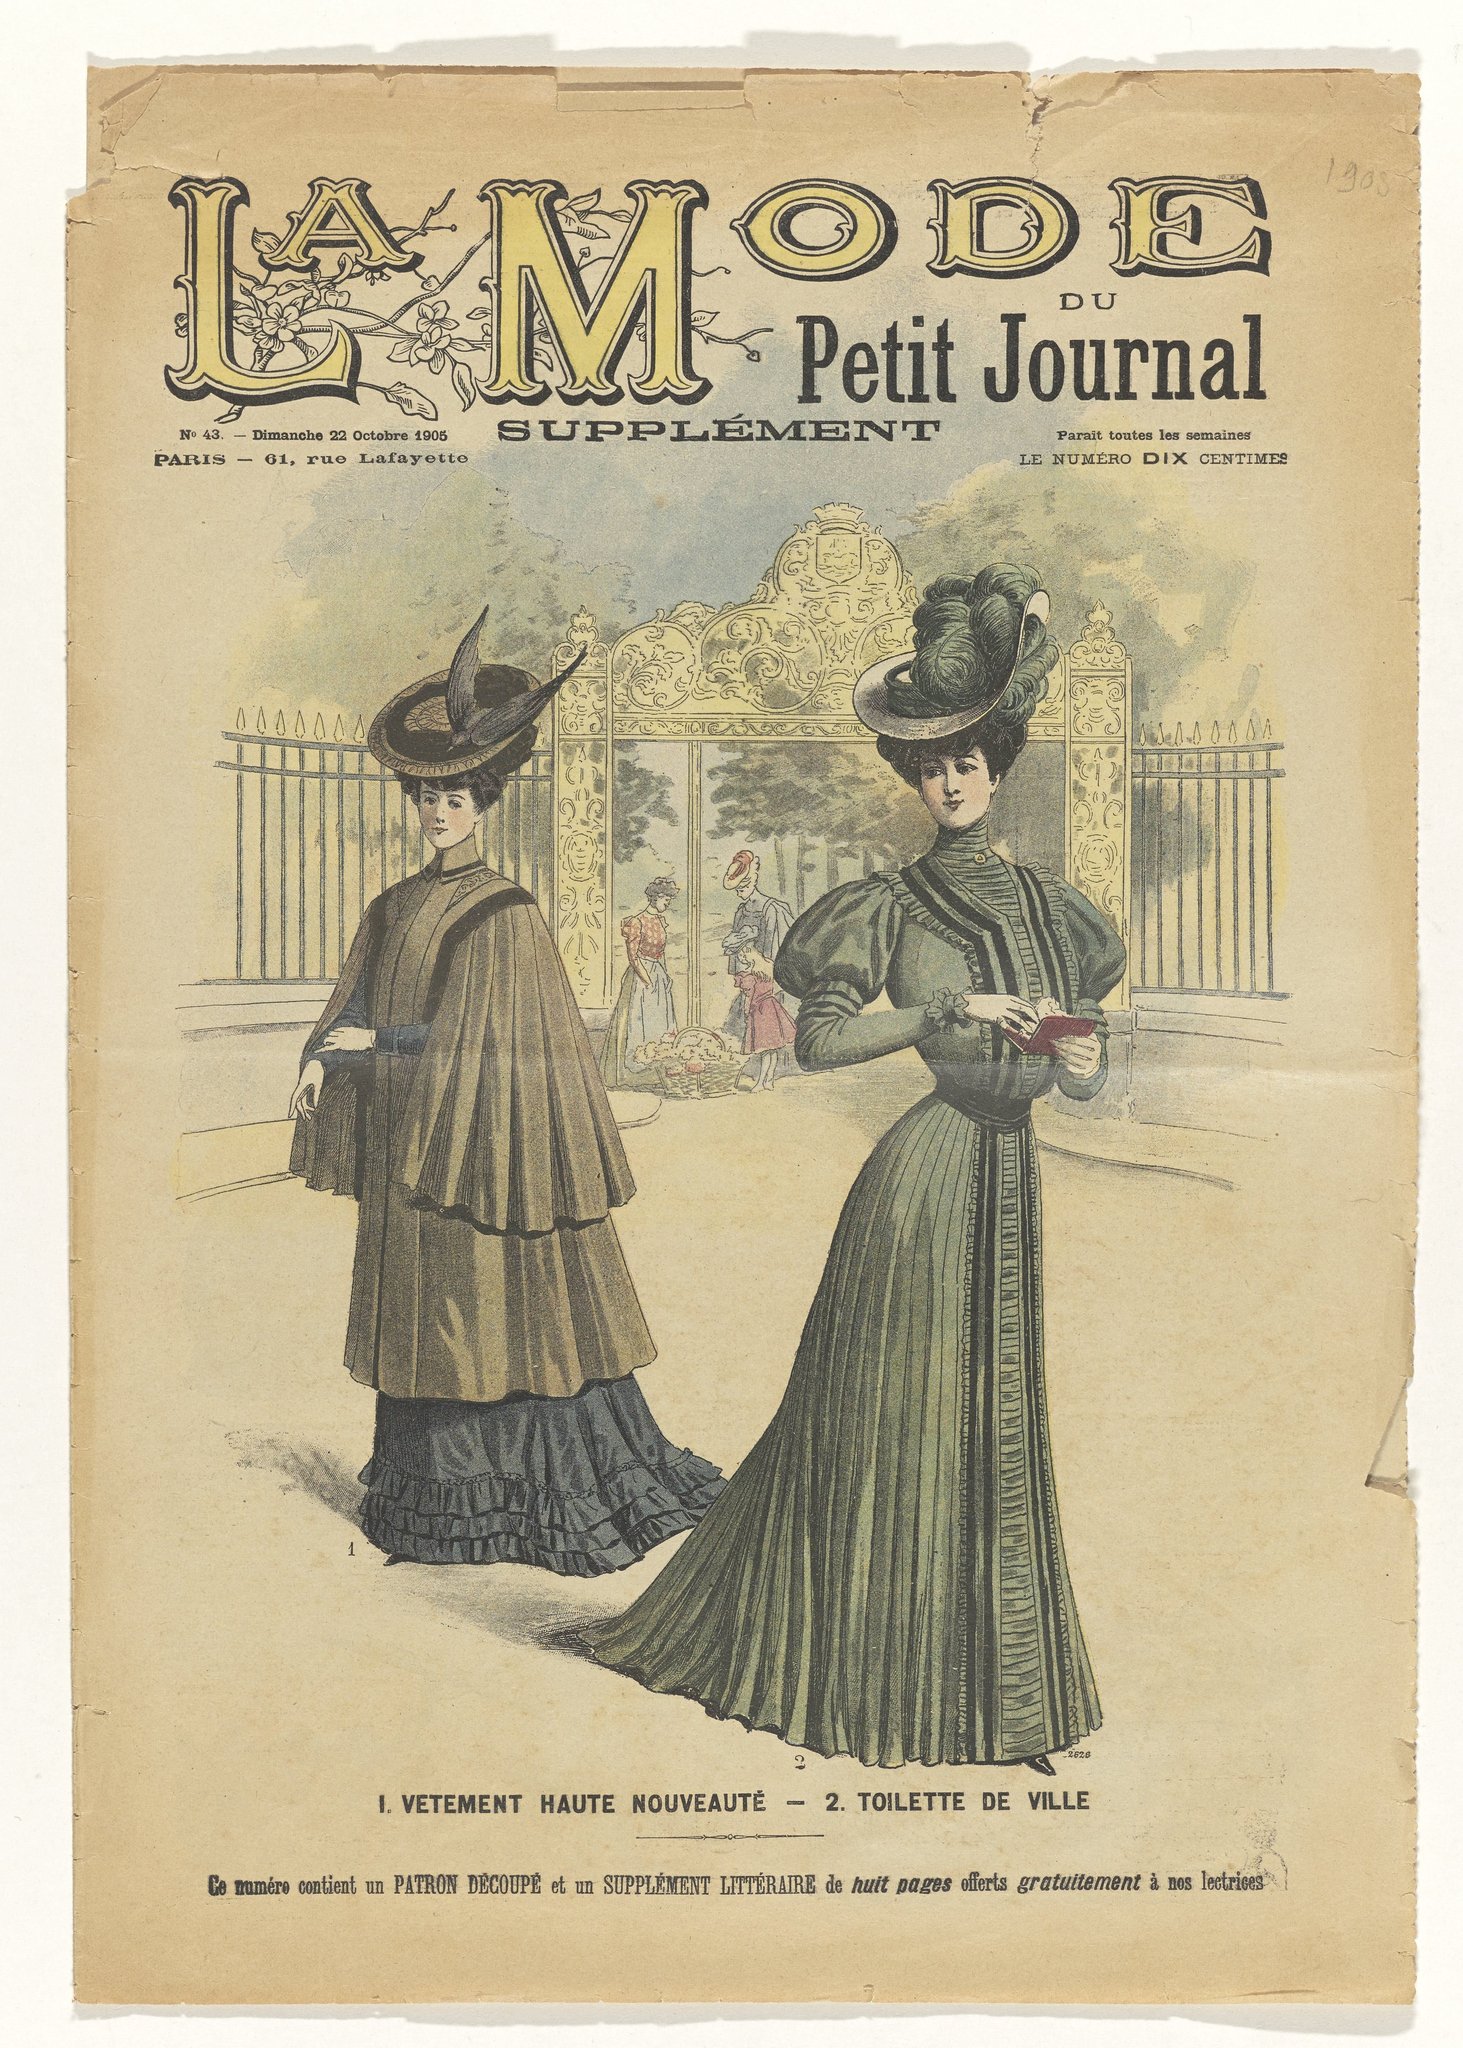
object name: fashion print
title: The Fashion Magazine as Temptress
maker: Anonymous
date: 1905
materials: paper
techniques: lithograph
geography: paris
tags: dress, gown: day dress (+ women's clothes), dress, gown (robe de ville) (+ women's clothes), coat: overcoat (+ women's clothes), fashion plates, head-gear: hat (+ women's clothes), muff (+ women's clothes)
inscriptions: title (false): ‘La Mode du Petit Journal: supplement, Nr. 43. - Dimanche 22 Octobre 1905’, caption (): ‘1. Vetement haute nouveauté. - 2. Toilette de ville’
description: The first fashion magazines were sold only by subscription. They have nondescript covers, with neither text nor image. This changed at the end of the 19th century when the publications came to be displayed in stands and shops. Publishers went to great lengths to entice potential buyers by means of attractive covers.